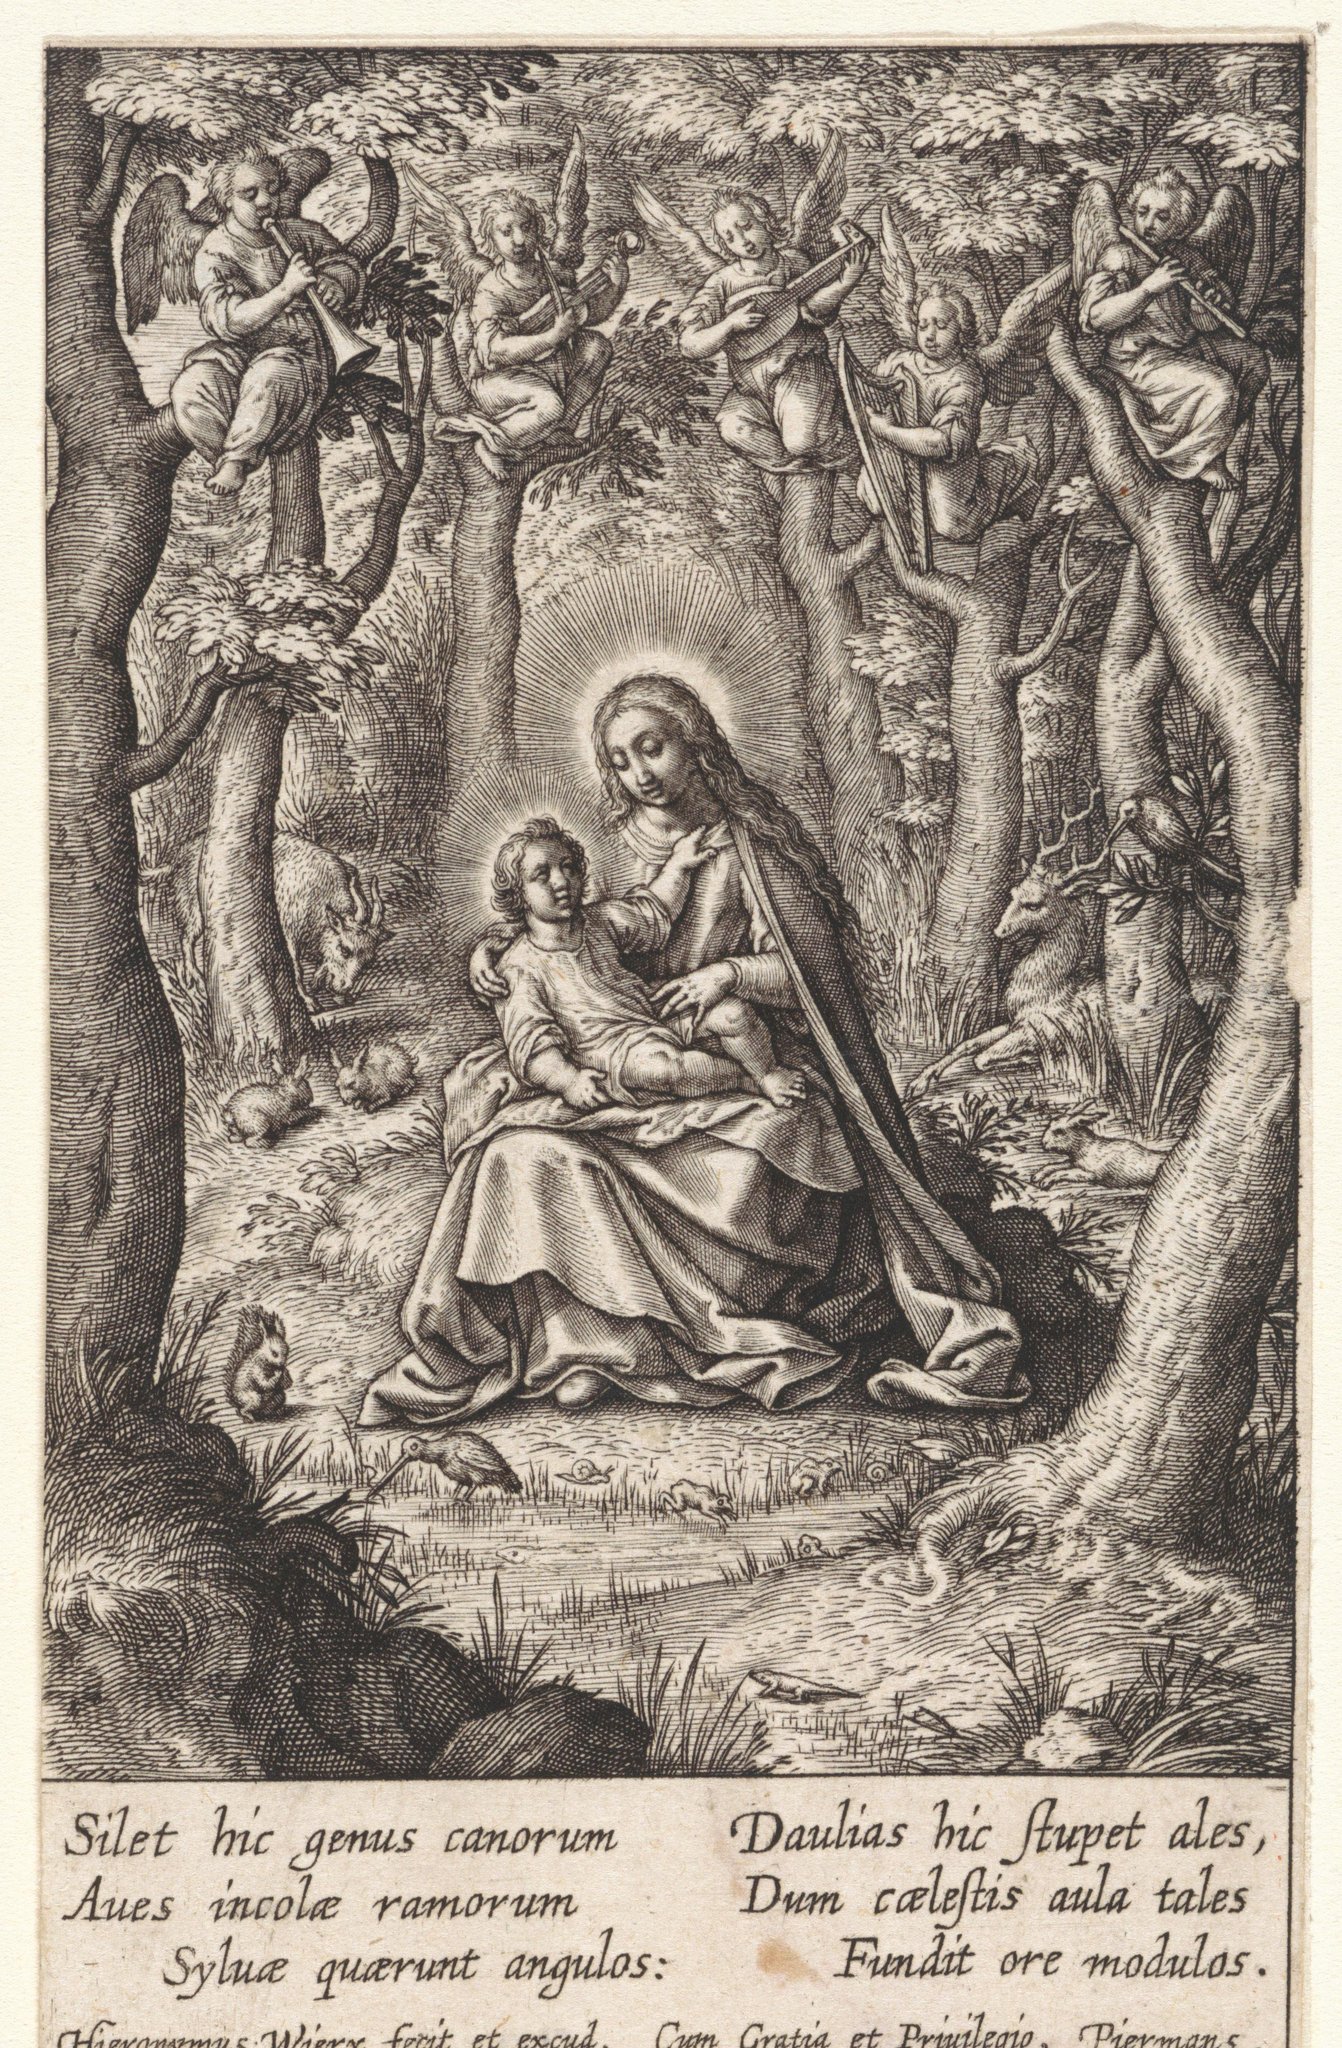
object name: print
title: Rest on the Flight into Egypt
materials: paper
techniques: engraving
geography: antwerp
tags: rest on the flight into egypt (+ angel(s))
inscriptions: collector's mark: Lugt 240, number: ‘70’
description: Maria zit met het Christuskind op schoot op een open plek in het bos. Ze worden omringd door verschillende dieren. Op de takken in de bomen rond hen zitten musicerende engelen. In de marge een zesregelig onderschrift, in twee kolommen, in het Latijn.